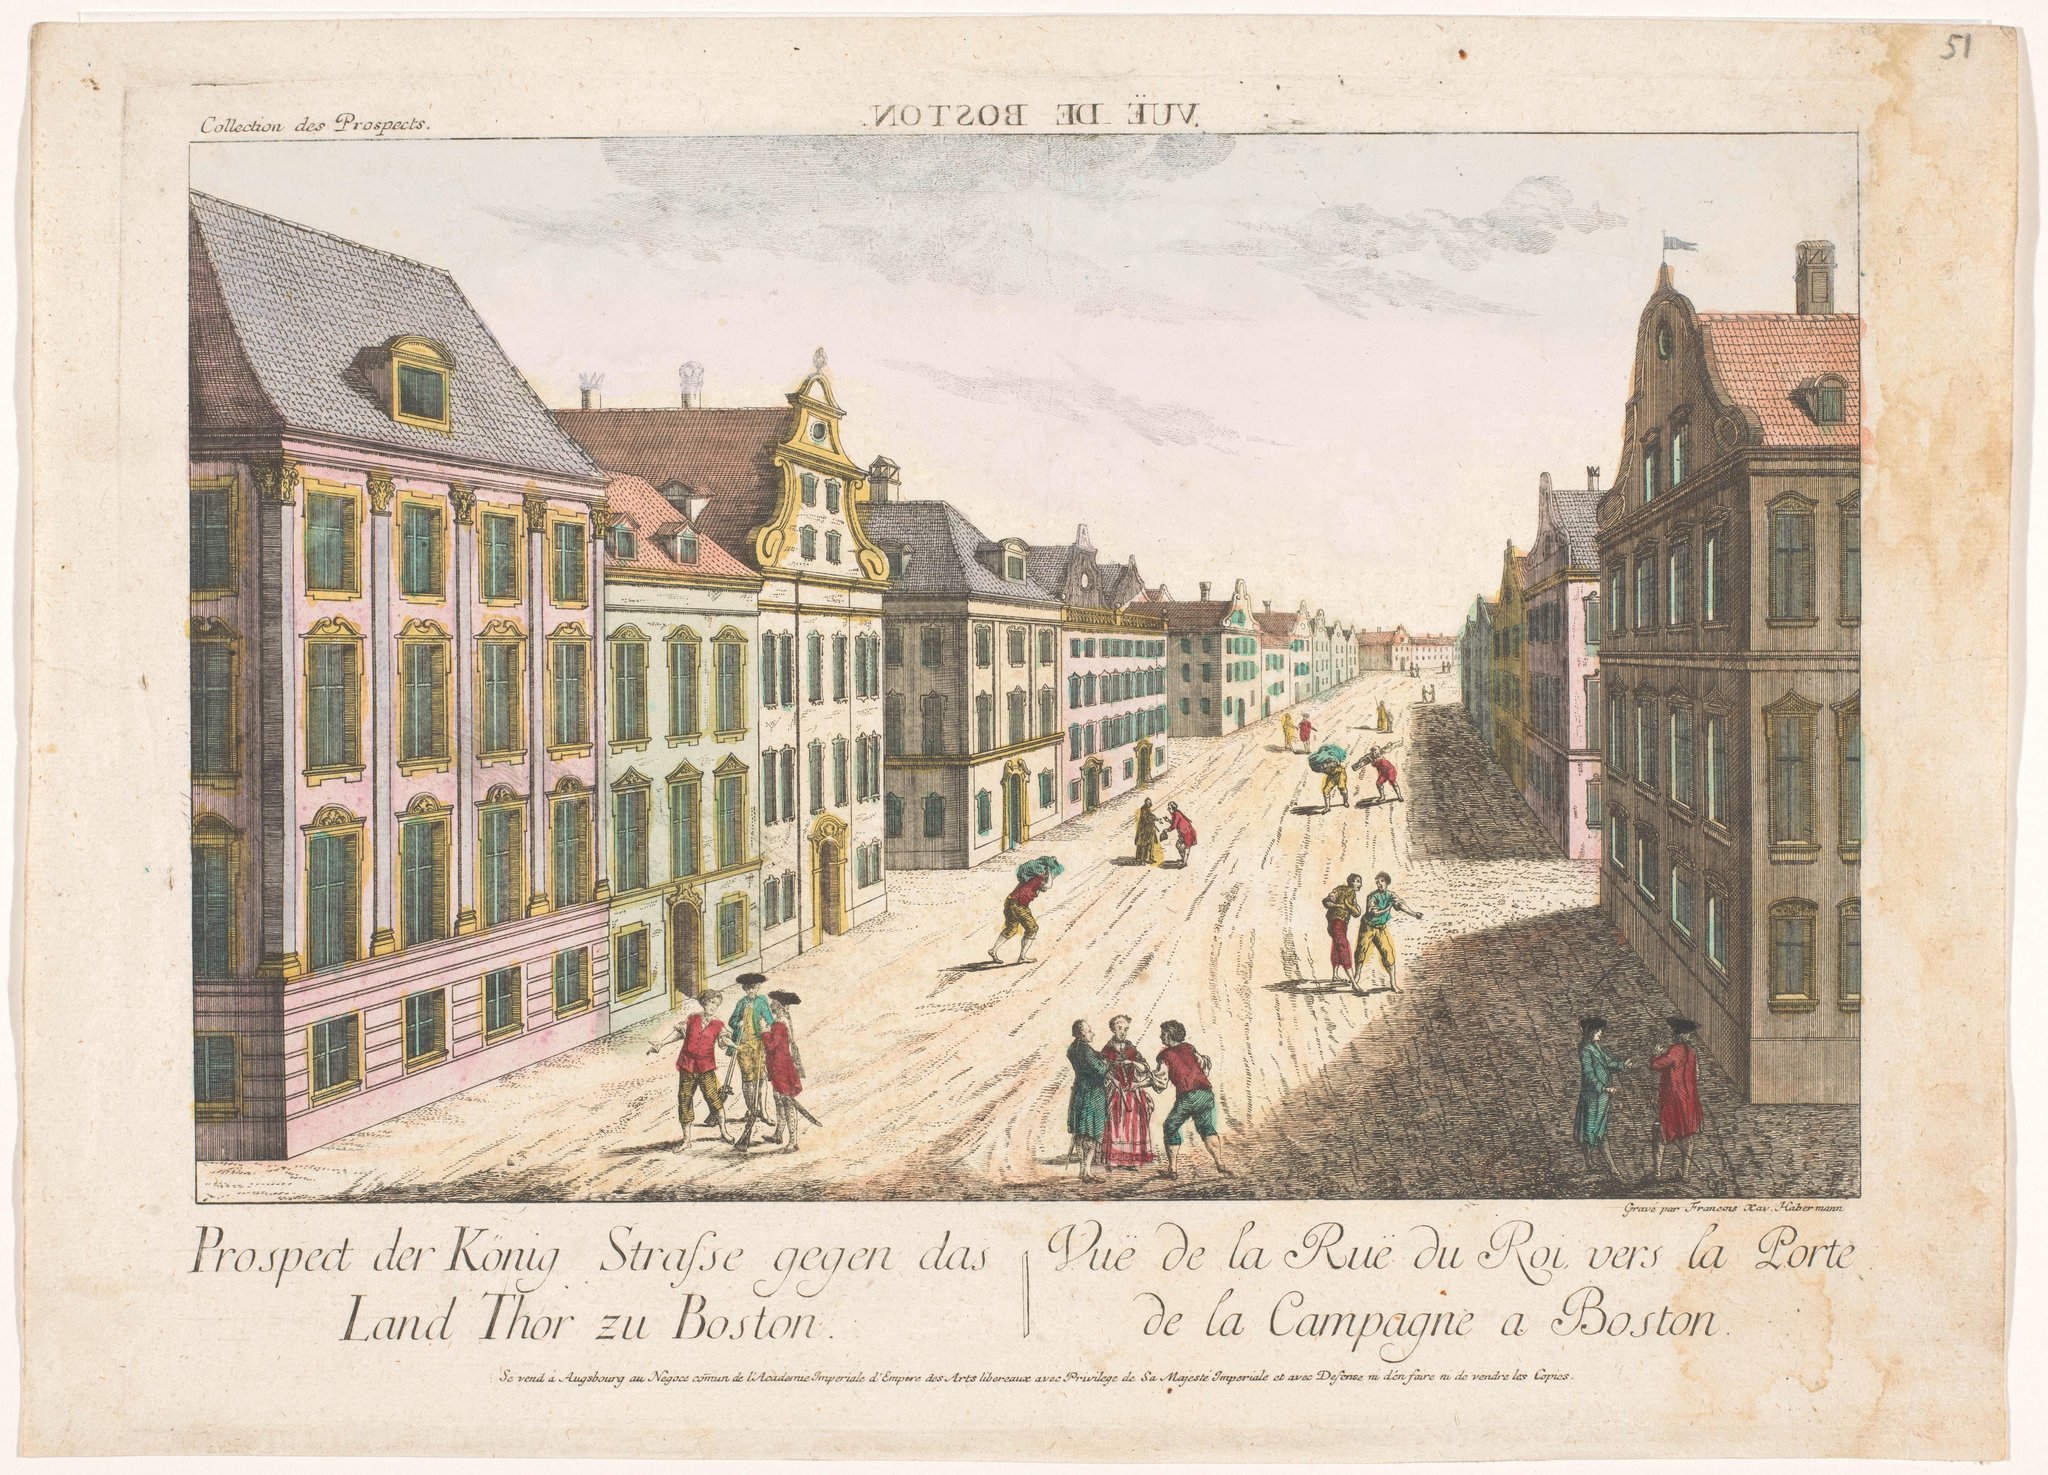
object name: print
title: Prospect der König Strasse gegen das Land Thor zu Boston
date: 1755-1779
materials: paper, watercolor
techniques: brush, etching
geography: augsburg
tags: street (+ city(-scape) with figures, staffage)